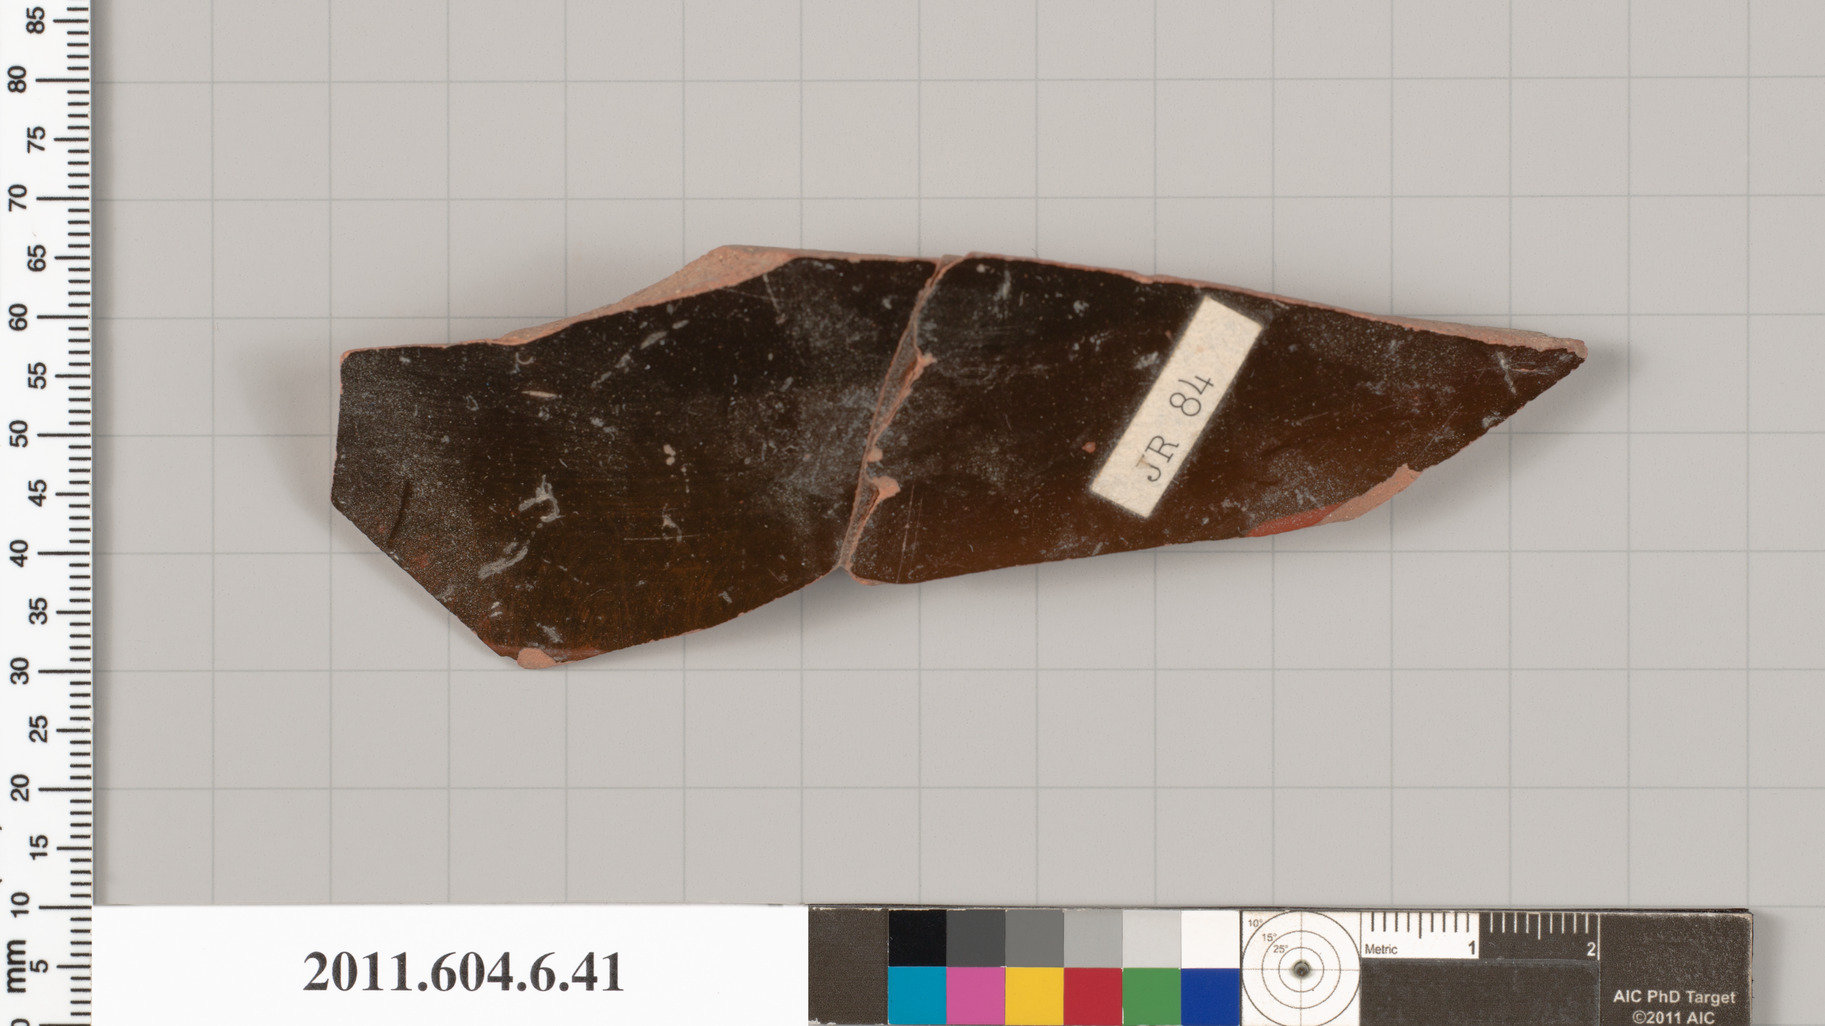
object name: undetermined closed shape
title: Terracotta fragment of a closed shape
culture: greek, attic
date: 600-401 BCE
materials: terracotta